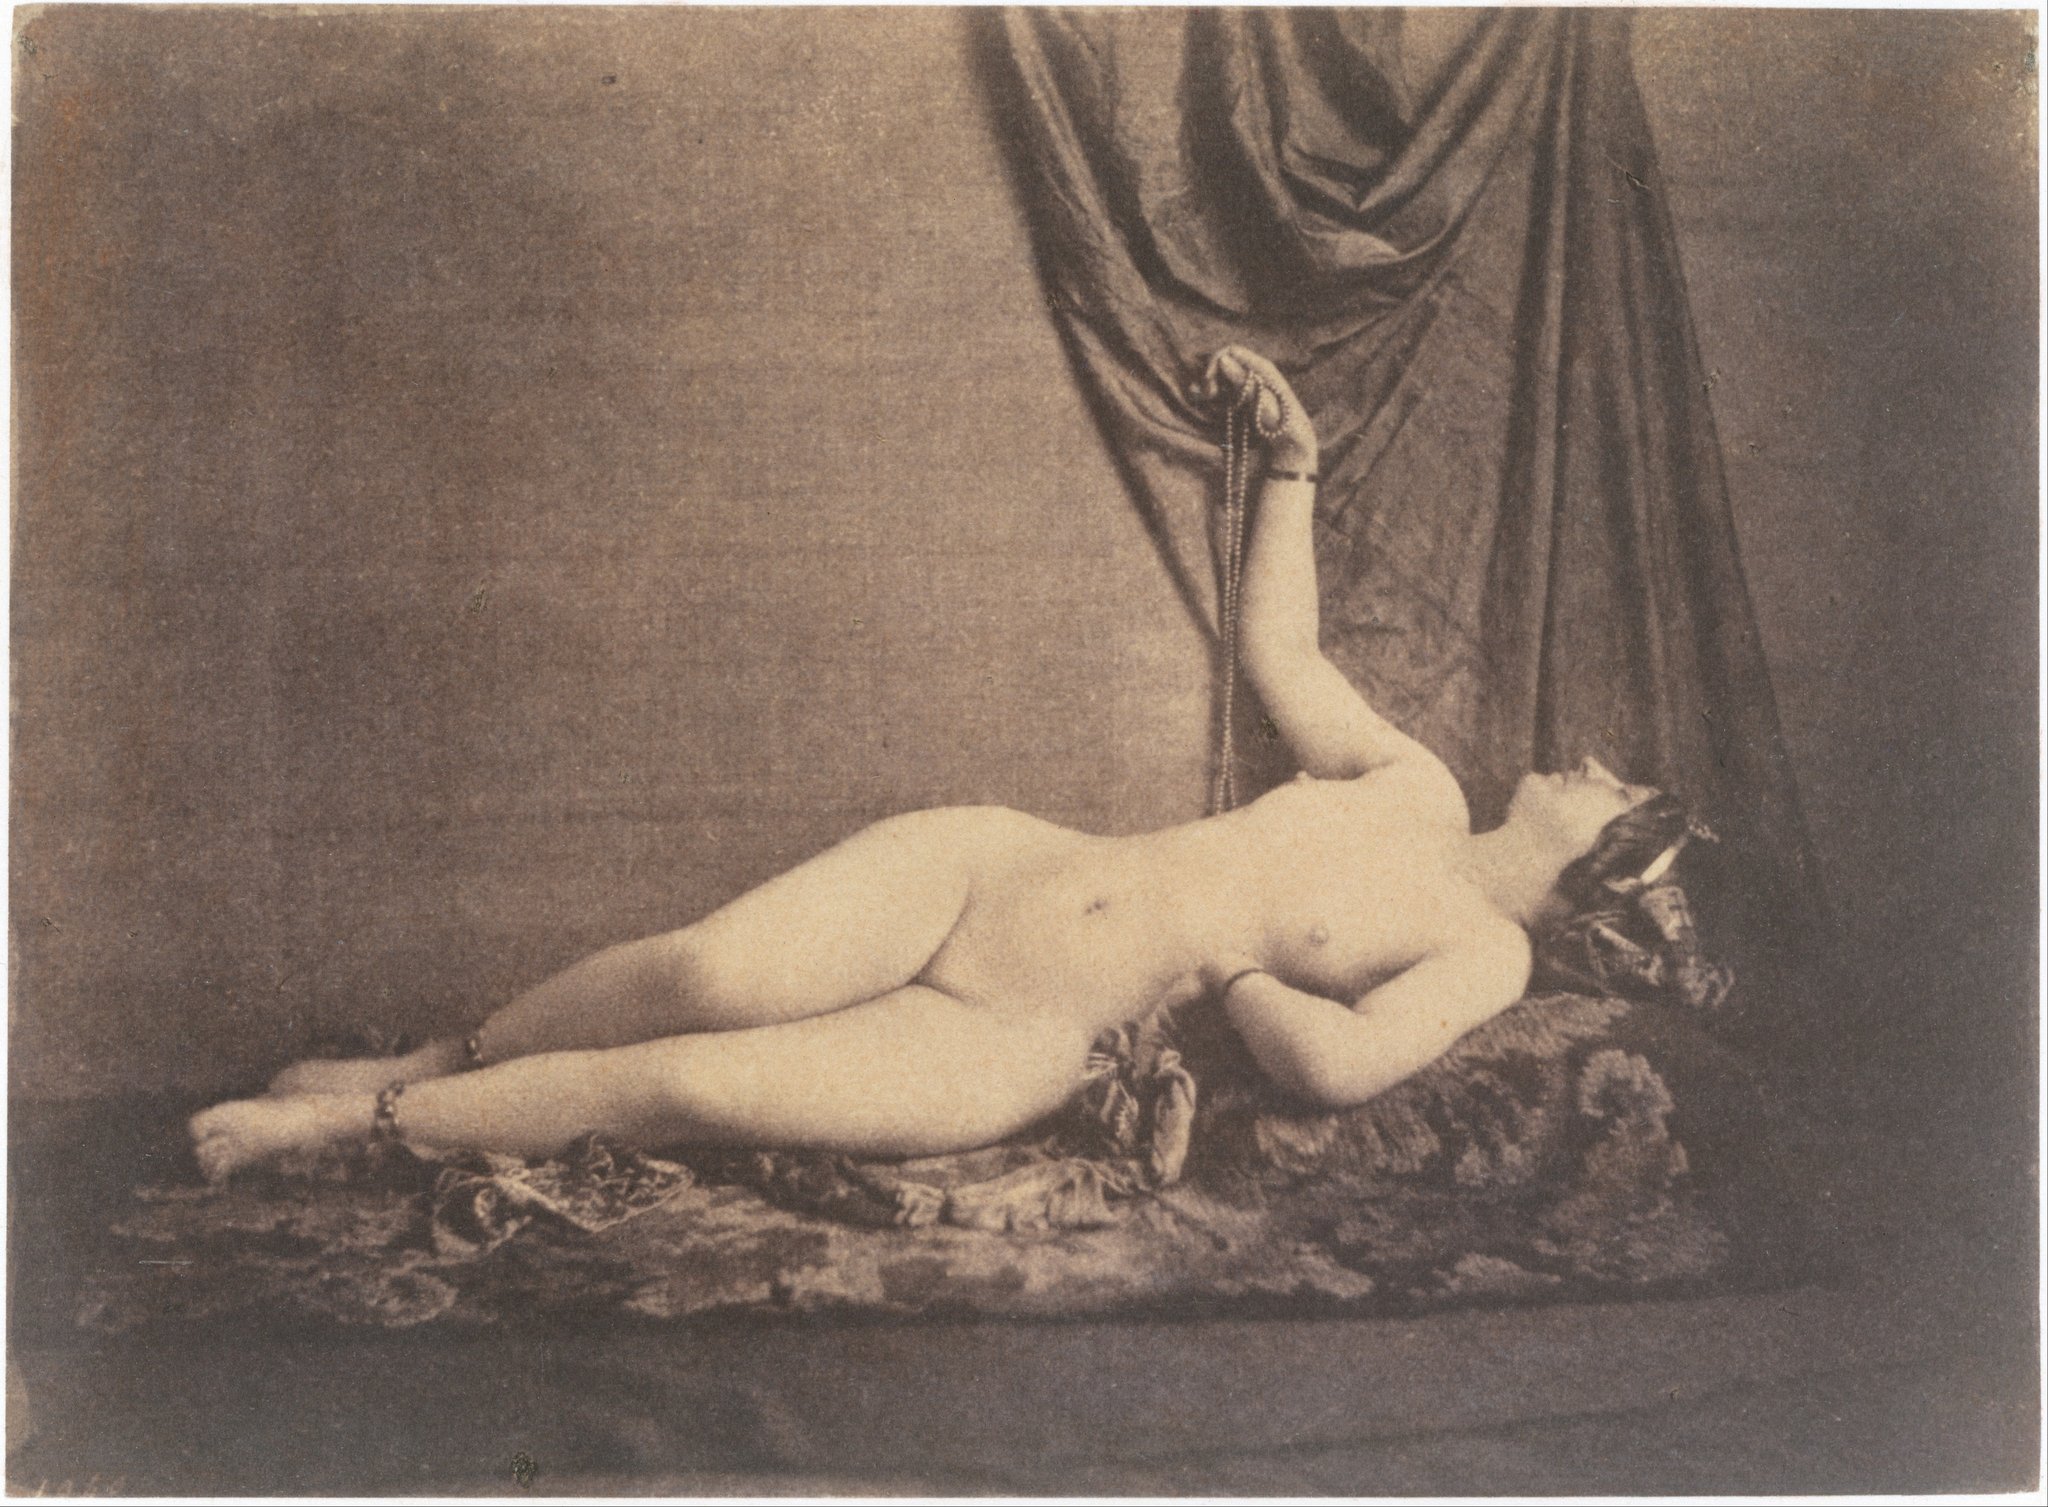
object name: photograph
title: [Reclining Female Nude]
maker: julien vallou de villeneuve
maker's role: artist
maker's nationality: french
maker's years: 1795-1866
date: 1853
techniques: paper negative, salted paper print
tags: female nudes